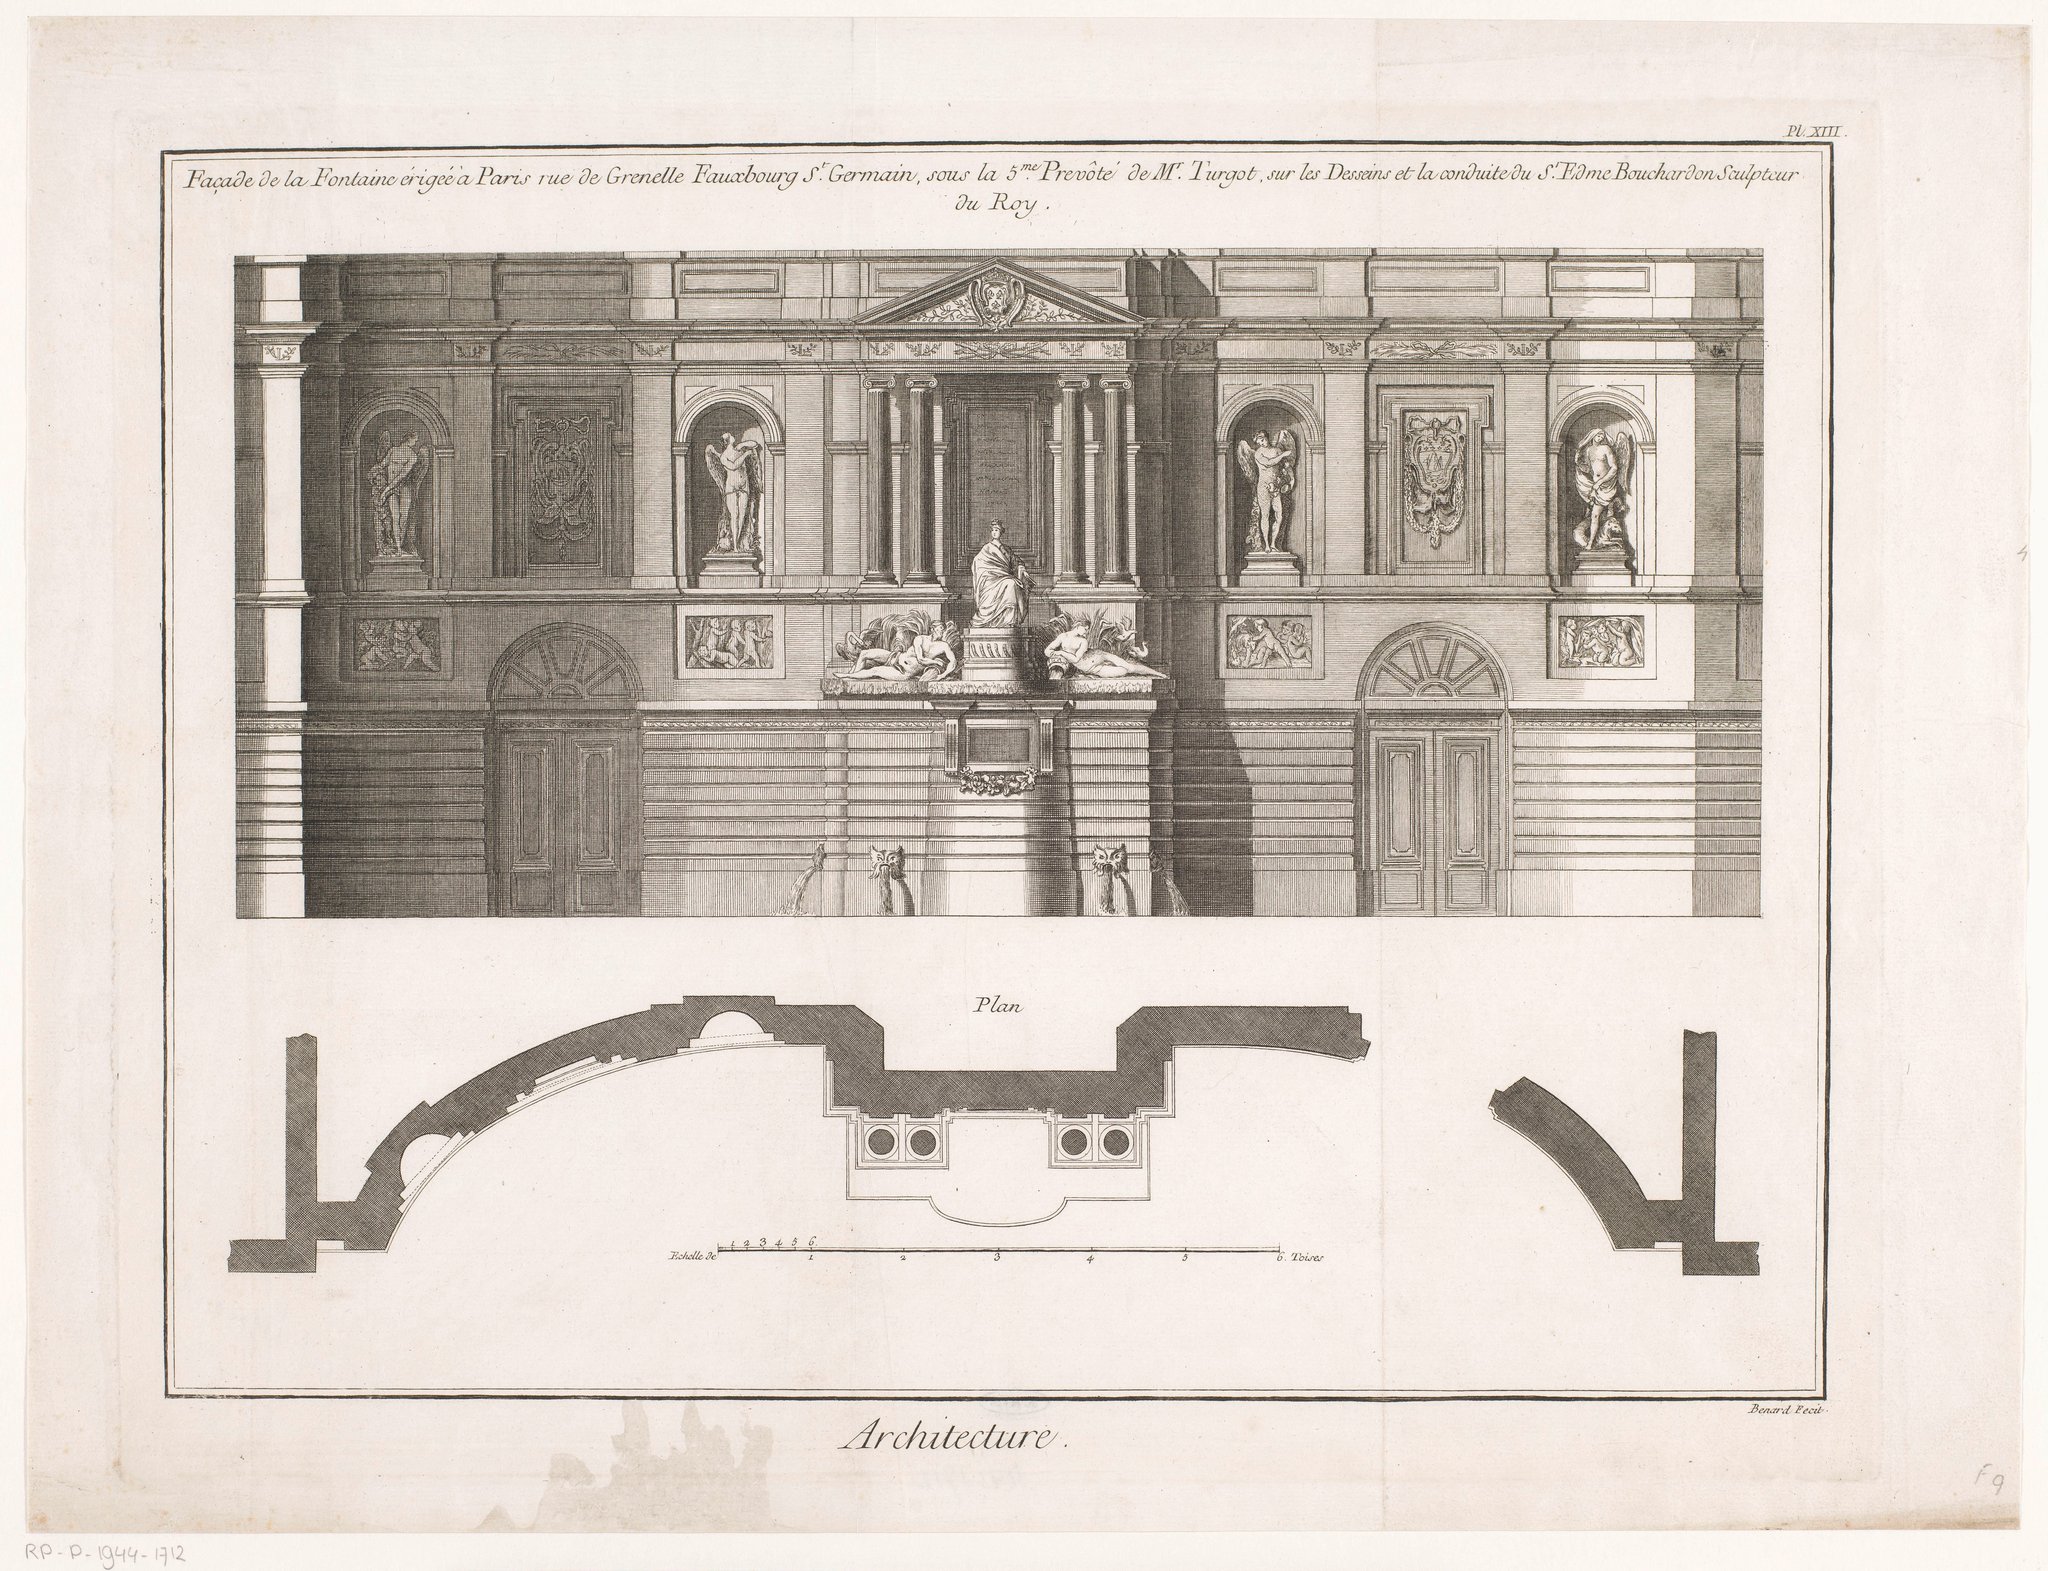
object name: print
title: Fontein van de vier seizoenen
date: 1745-1800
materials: paper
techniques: engraving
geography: paris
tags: year divided into four seasons, ornamental fountain, paris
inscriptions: collector's mark: Lugt 2228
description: Vooraanzicht en plattegrond van de fontein van de vier seizoenen in Parijs tegen een ionische tempelgevel. In het midden zit een vrouwelijke personificatie van Parijs op een troon met aan haar voeten twee liggende figuren als personificaties van de rivieren de Marne en de Seine. Aan de onderzijde vier maskers met waterstralen. Links en rechts reliëfs met putti als allegorieën van de vier seizoenen: de Lente bekranst zich met bloemen, de Zomer is aan het maaien, de Herfst verleest de wijn en de Winter verwarmt zich. Boven de reliëfs staan engelen met seizoensgebonden fruit in nissen. Rechts boven Pl. XIII.